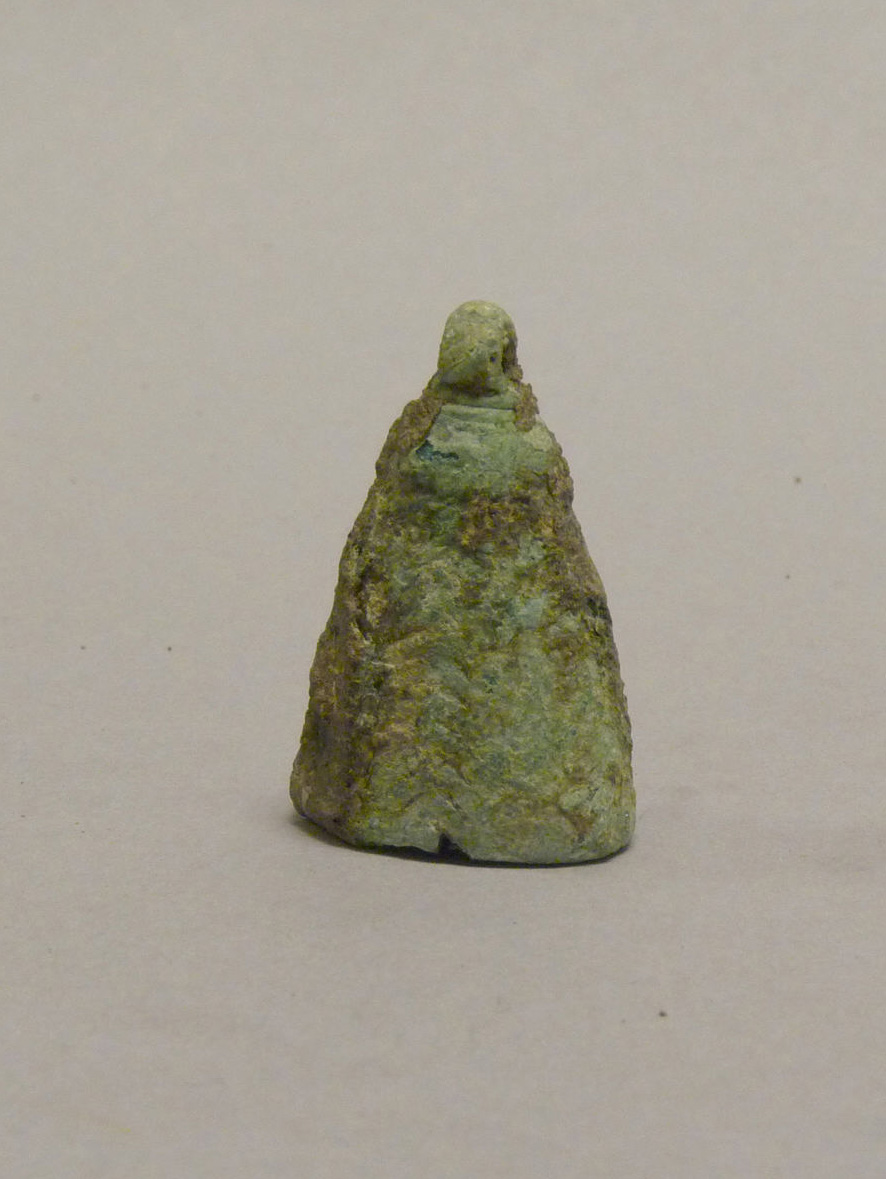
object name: bell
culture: thai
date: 500 BCE-300 CE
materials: bronze